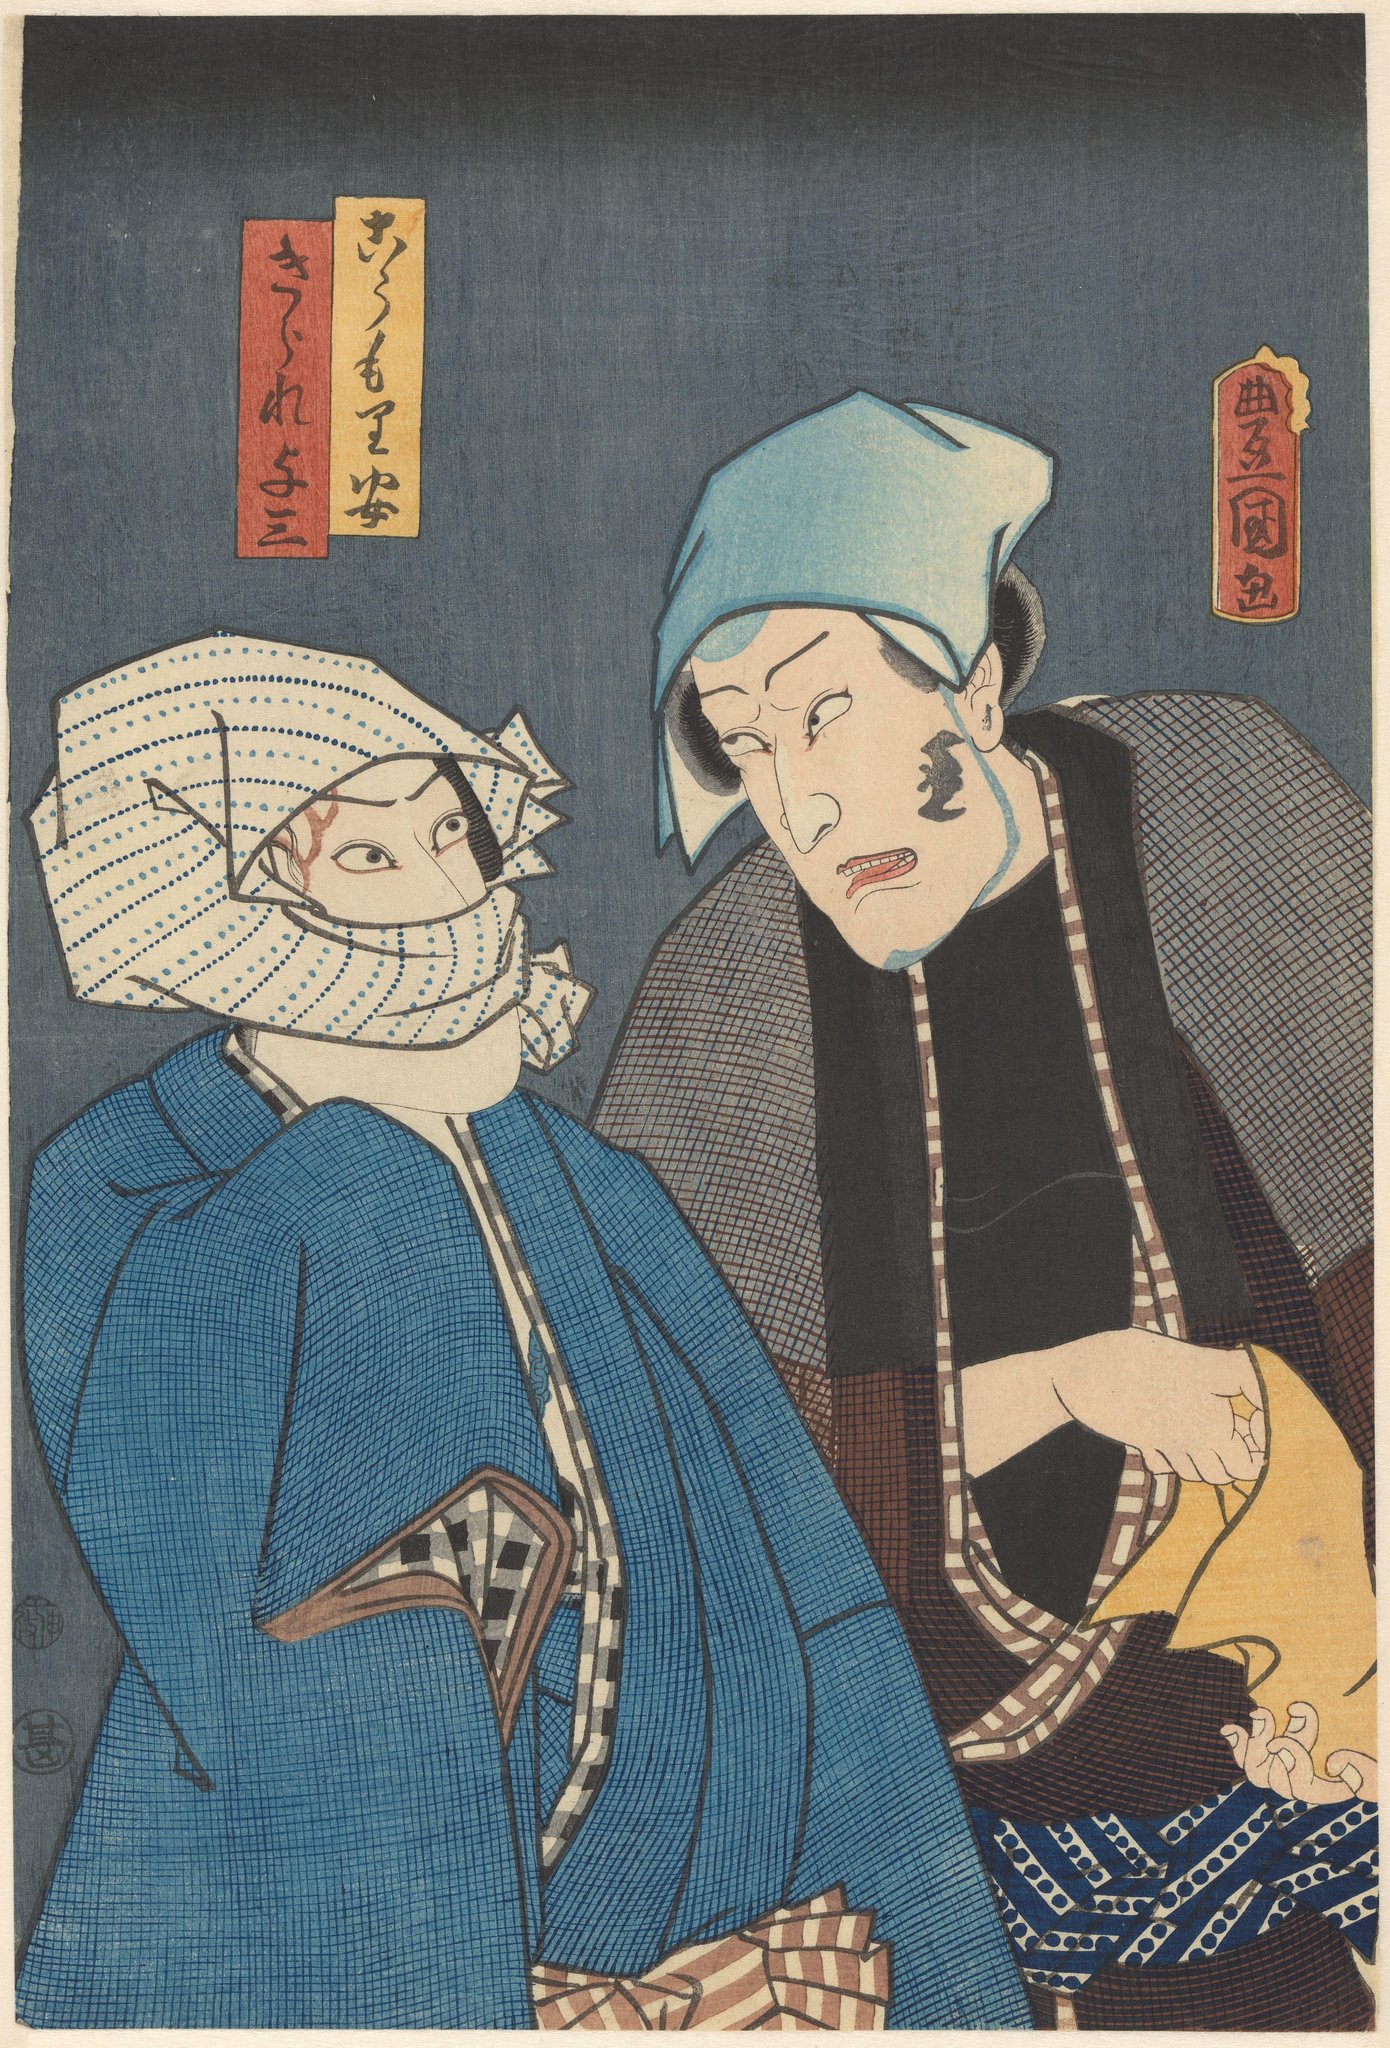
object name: print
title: Kômori Yasugorô and Kirare Yosaburô conspiring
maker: utagawa kunisada (i)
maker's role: print maker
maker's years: 1786-1865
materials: paper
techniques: woodcut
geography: japan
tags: head-gear (with name), group of actors, troupe; actors on the stage, tattoo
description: Kômori Yasugorô met kenmerkende vleermuistatoeage op zijn wang een complot smedend met Kirare Yosaburô. Beiden dragen een hoofddoek. Kômori Yasugorô wordt gespeeld door kabuki acteur Ichikawa Kodanji IV en Kirare Yosaburô door Kawarasaki Gonjurô I.